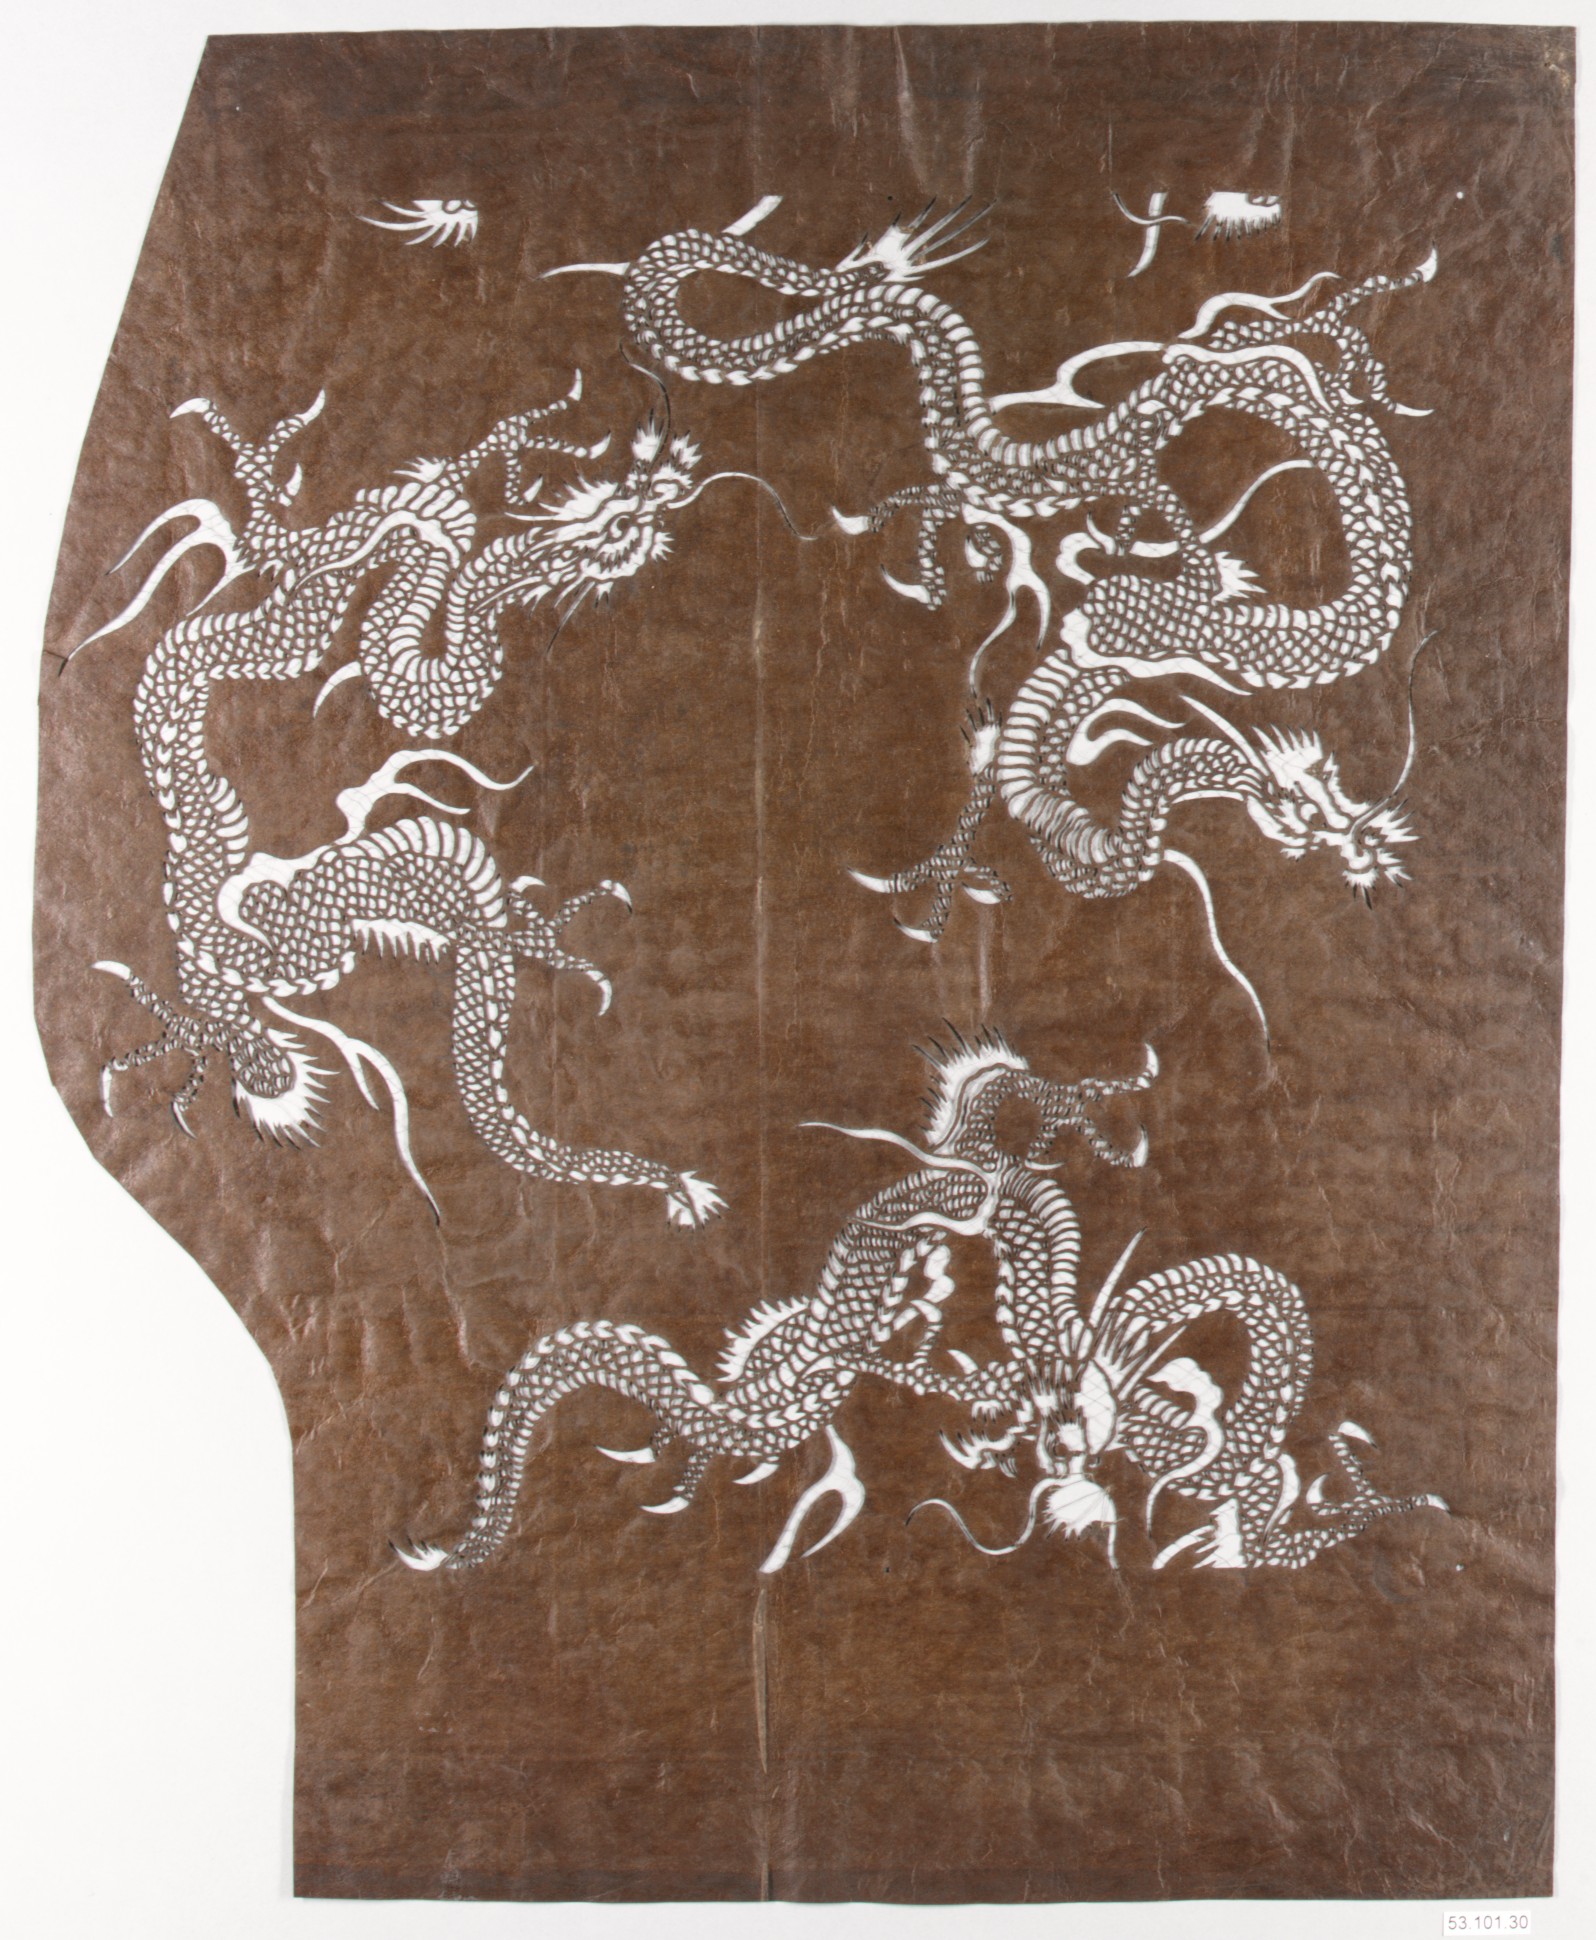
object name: stencil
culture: japanese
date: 1615-1868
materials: paper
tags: dragons